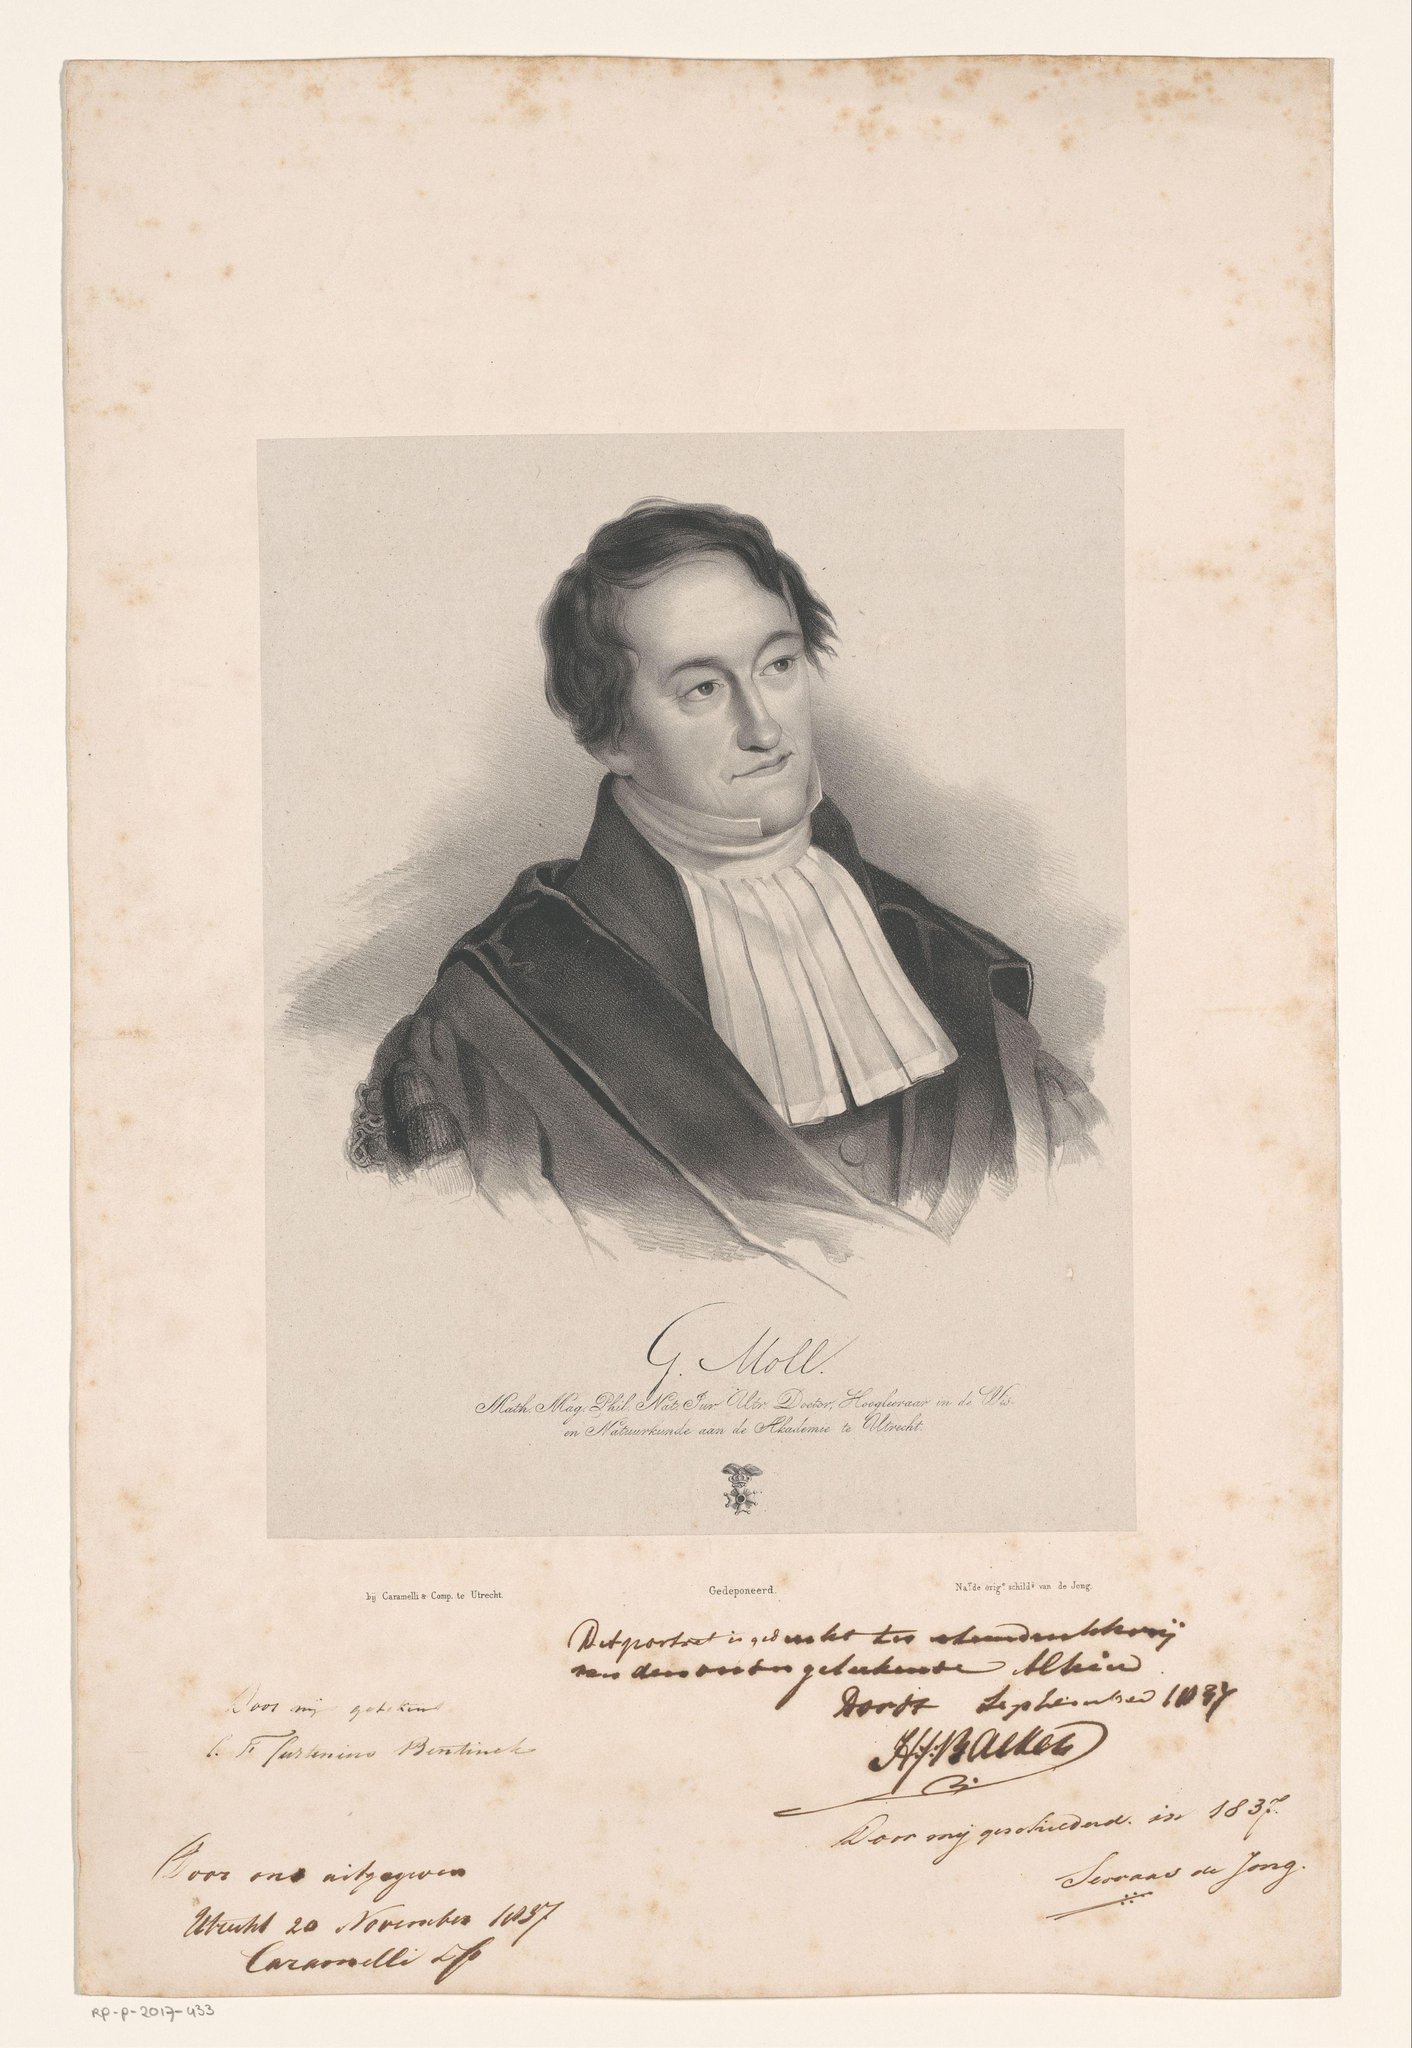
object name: print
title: Portret van Gerrit Moll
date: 1837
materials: paper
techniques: lithograph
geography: utrecht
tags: historical persons (+ (full) bust portrait)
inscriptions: : ‘Gedeponeerd.’, : ‘Door mij geschilderd in 1837 / Servaas de Jong’, : ‘Door mij getekend / C. F. Curtenius Bentinck’, : ‘Door ons uitgegeven / Utrecht 20 November 1837 / Caramelli &Co’, : ‘Dit portret is gedrukt ter steendrukkerij / van den ondergeteekende alhier / Dordt. (...) 1837 / H:J:Backer’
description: Onder het portret de signatuur van de geportretteerde.